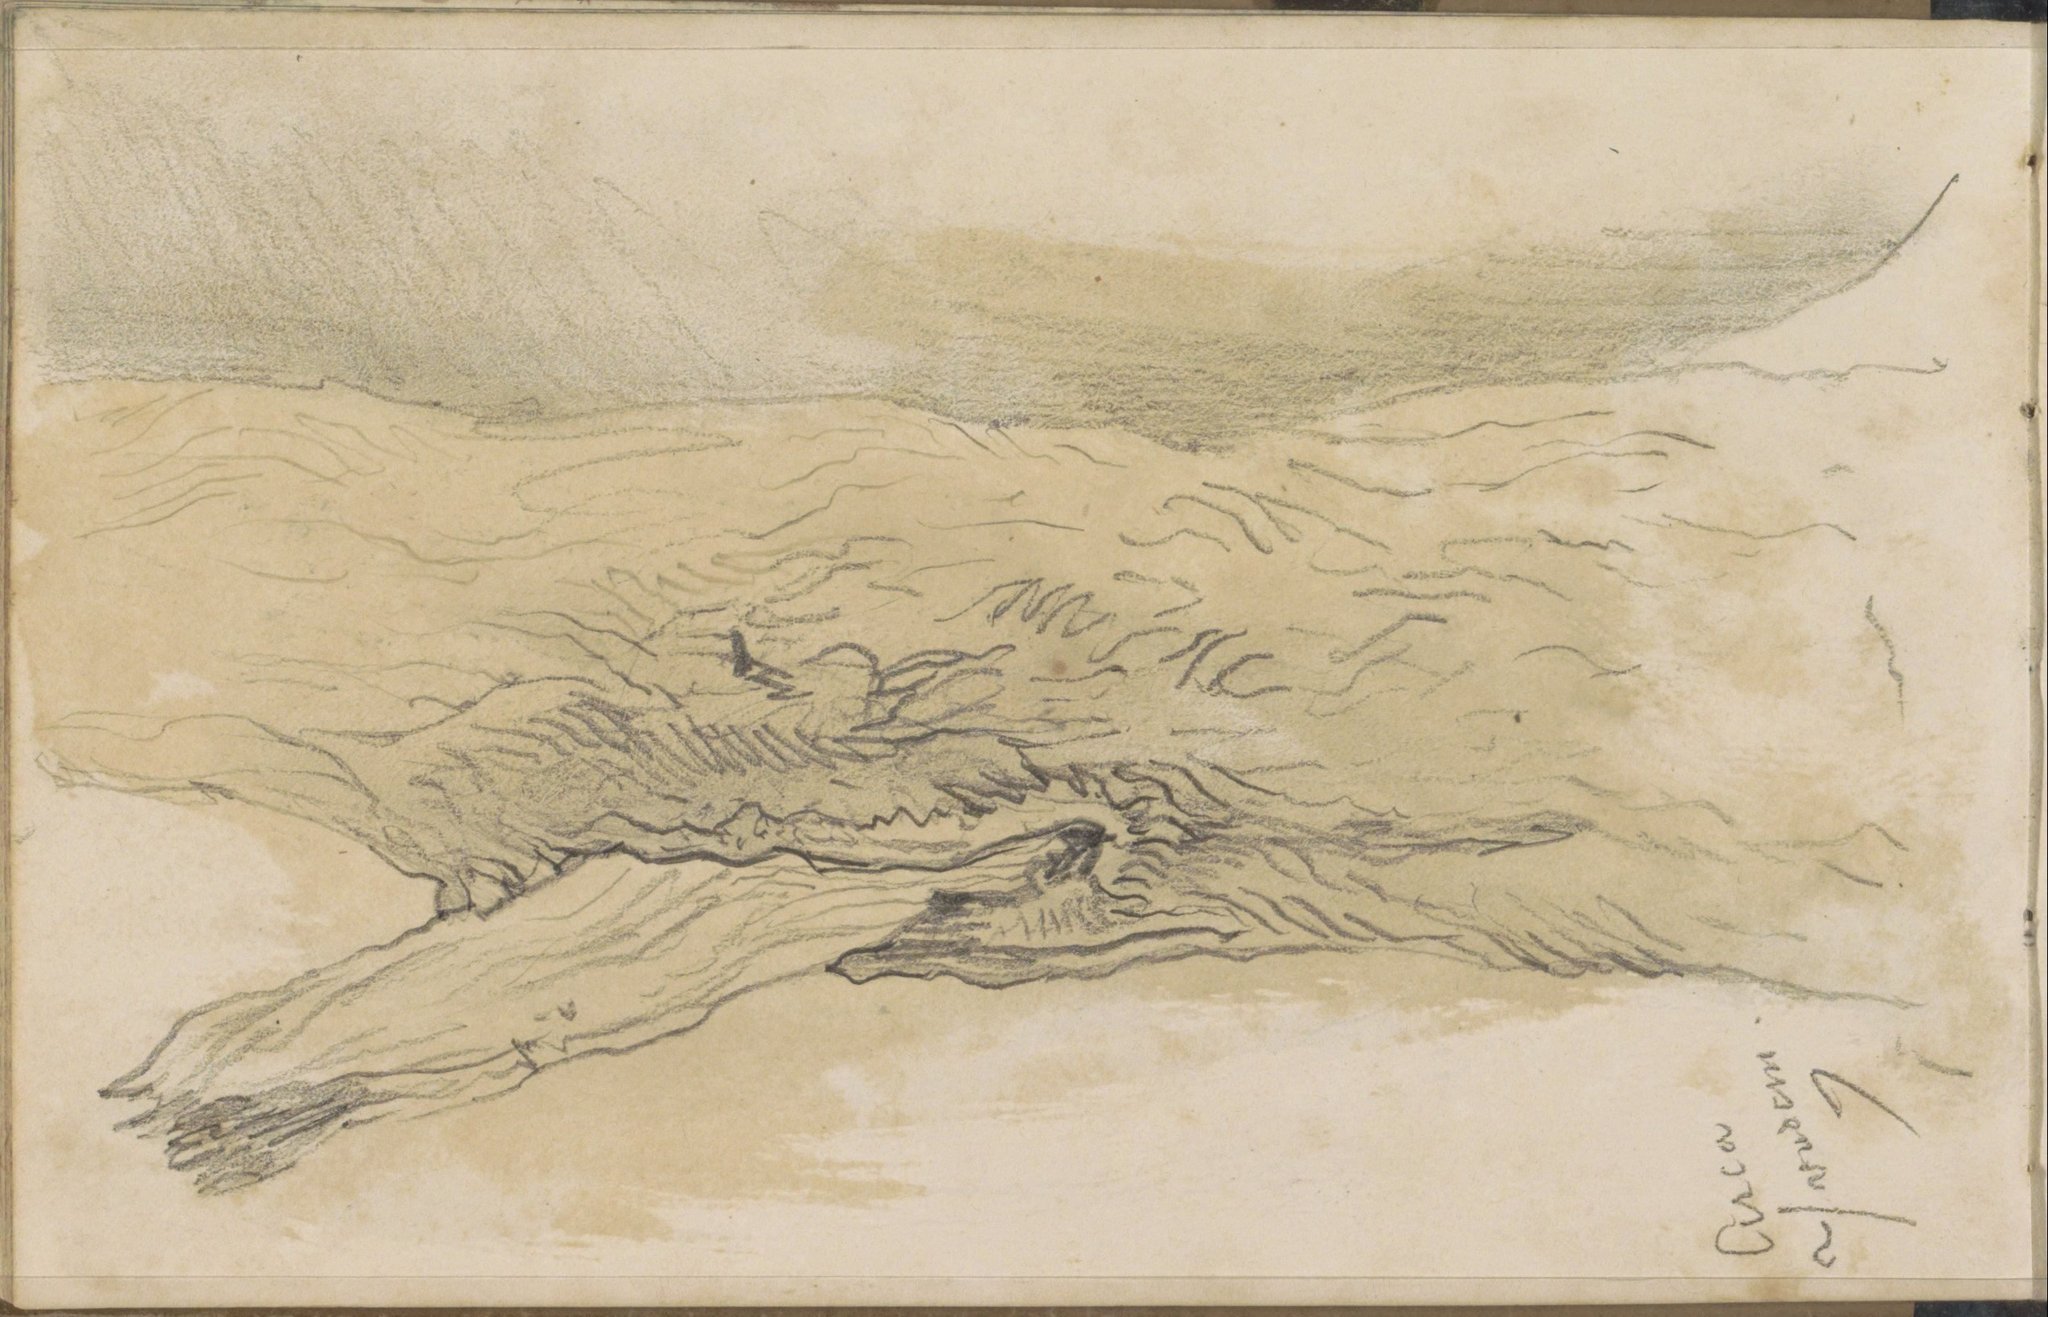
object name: sketchbook leaf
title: Stam van een eikenboom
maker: johannes tavenraat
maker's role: draughtsman, painter, print maker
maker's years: 1809-1881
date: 1810-1868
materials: paper, pencil, watercolor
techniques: brush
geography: the hague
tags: trees: oak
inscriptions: annotation: ‘circa/ 2 [...]cm’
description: Blad 13 verso uit een schetsboek met 48 bladen.